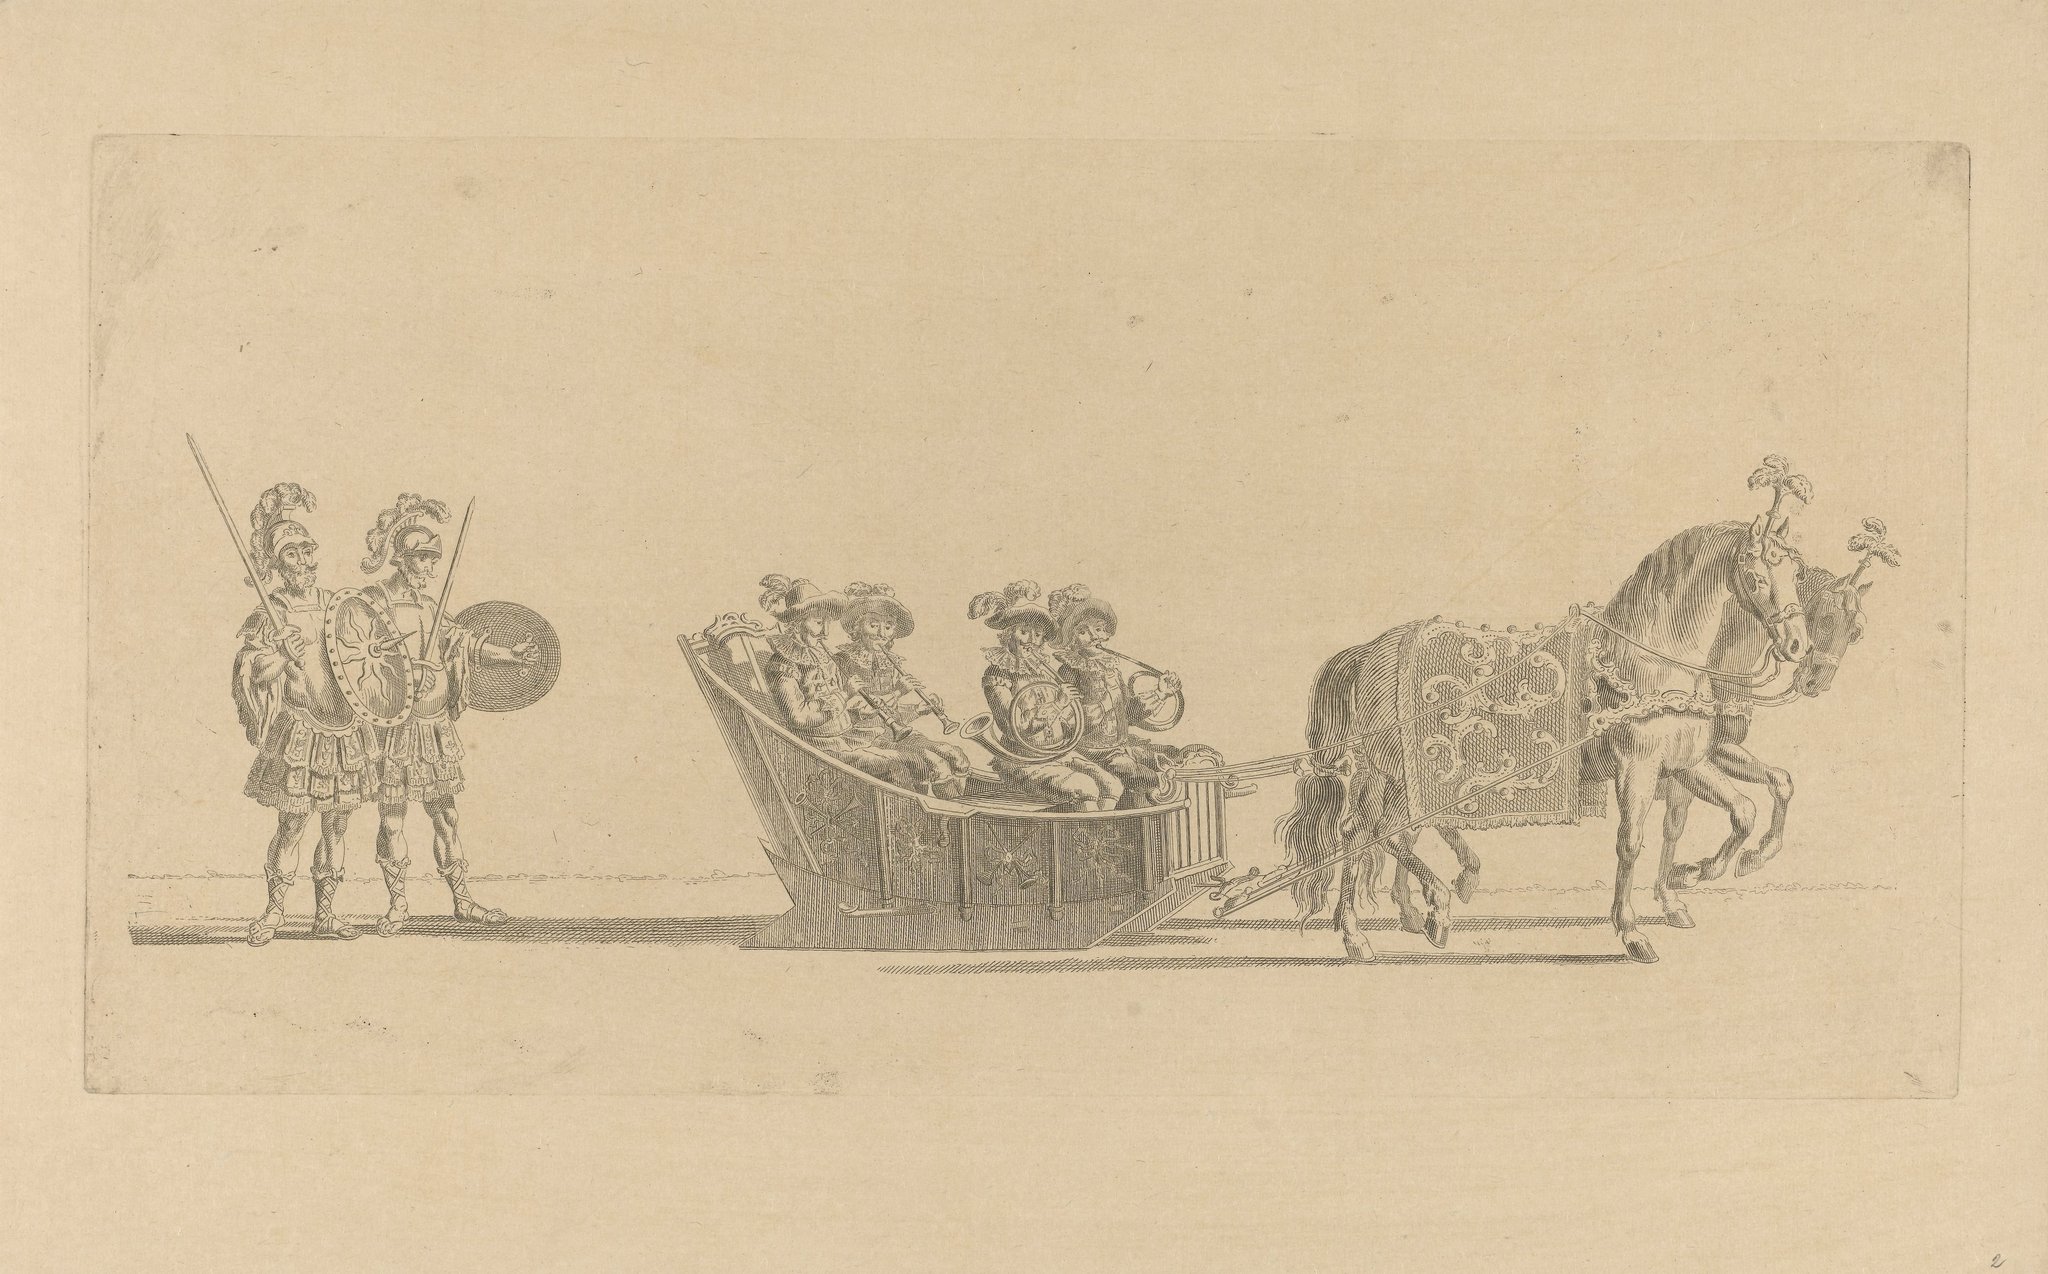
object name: print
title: Tweede slede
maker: nicolaas van der worm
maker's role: draughtsman, print maker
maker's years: 1757-1828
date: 1776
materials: paper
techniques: etching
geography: northern netherlands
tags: sledge, sleigh (winter sports), commemoration of the founding of a university, leiden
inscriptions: collector's mark: Lugt 240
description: De tweede slede in de optocht. Een grote slede met vier muzikanten getrokken door twee paarden en gevolgd door twee Romeinen met zwaarden. Onderdeel van een reeks van twaalf platen (etsdruk vóór het nummer en op ander papier) van de sledevaart op 24 januari 1776 georganiseerd door het Leidse genootschap Veniam Pro Laude bij gelegenheid van het Tweede Eeuwfeest van het Leids Ontzet (3 oktober 1574) en de oprichting van de Universiteit van Leiden (8 februari 1575).